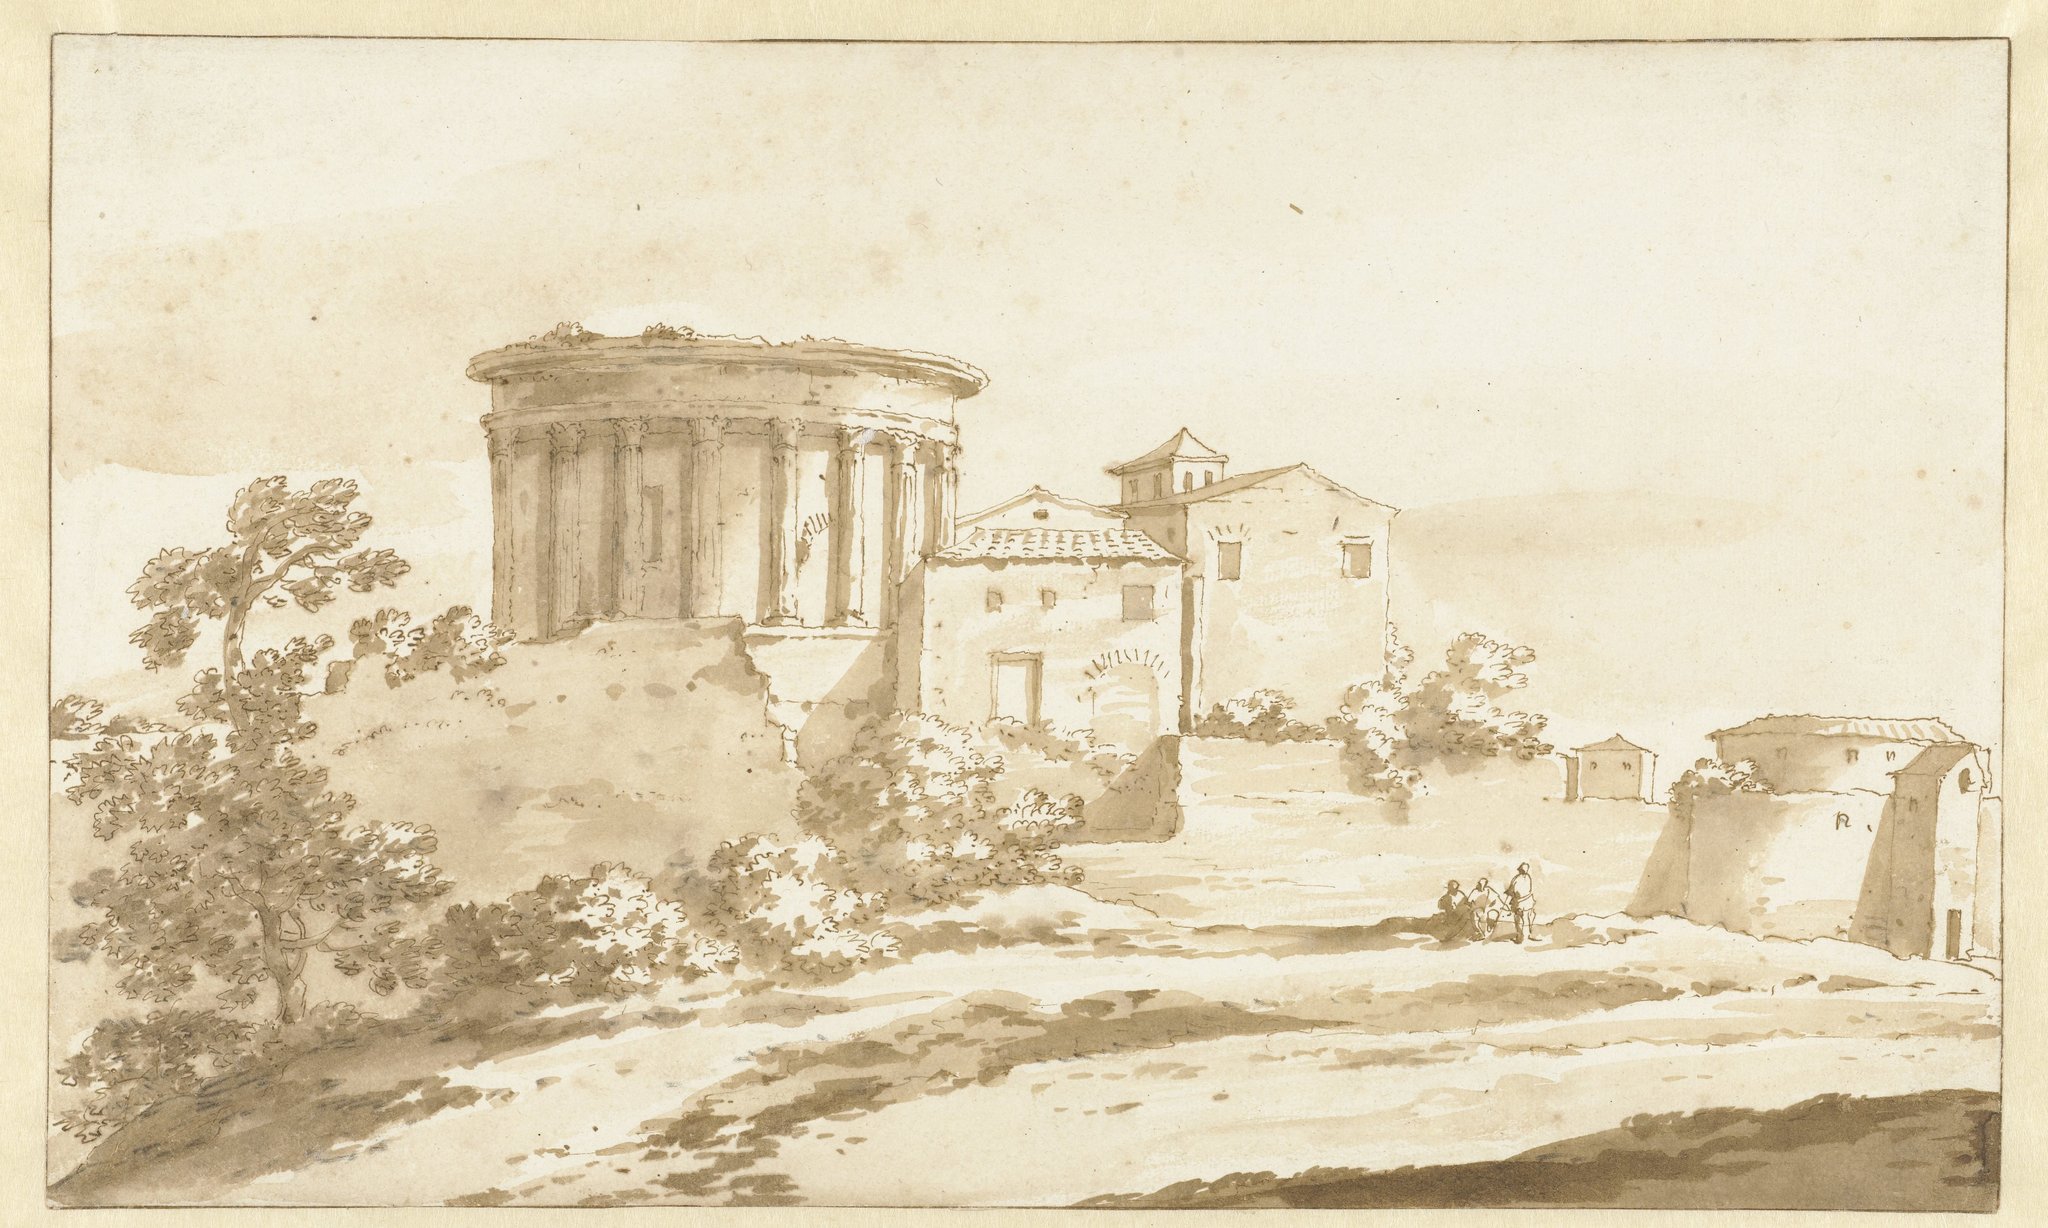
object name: drawing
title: Het tempeltje van de Sibylle te Tivoli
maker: jacob van der ulft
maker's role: draughtsman, painter, print maker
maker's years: 1627-1689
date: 1637-1689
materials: chalk, graphite, ink, paper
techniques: brush, pen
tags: ruin of a building ~ architecture, tivoli